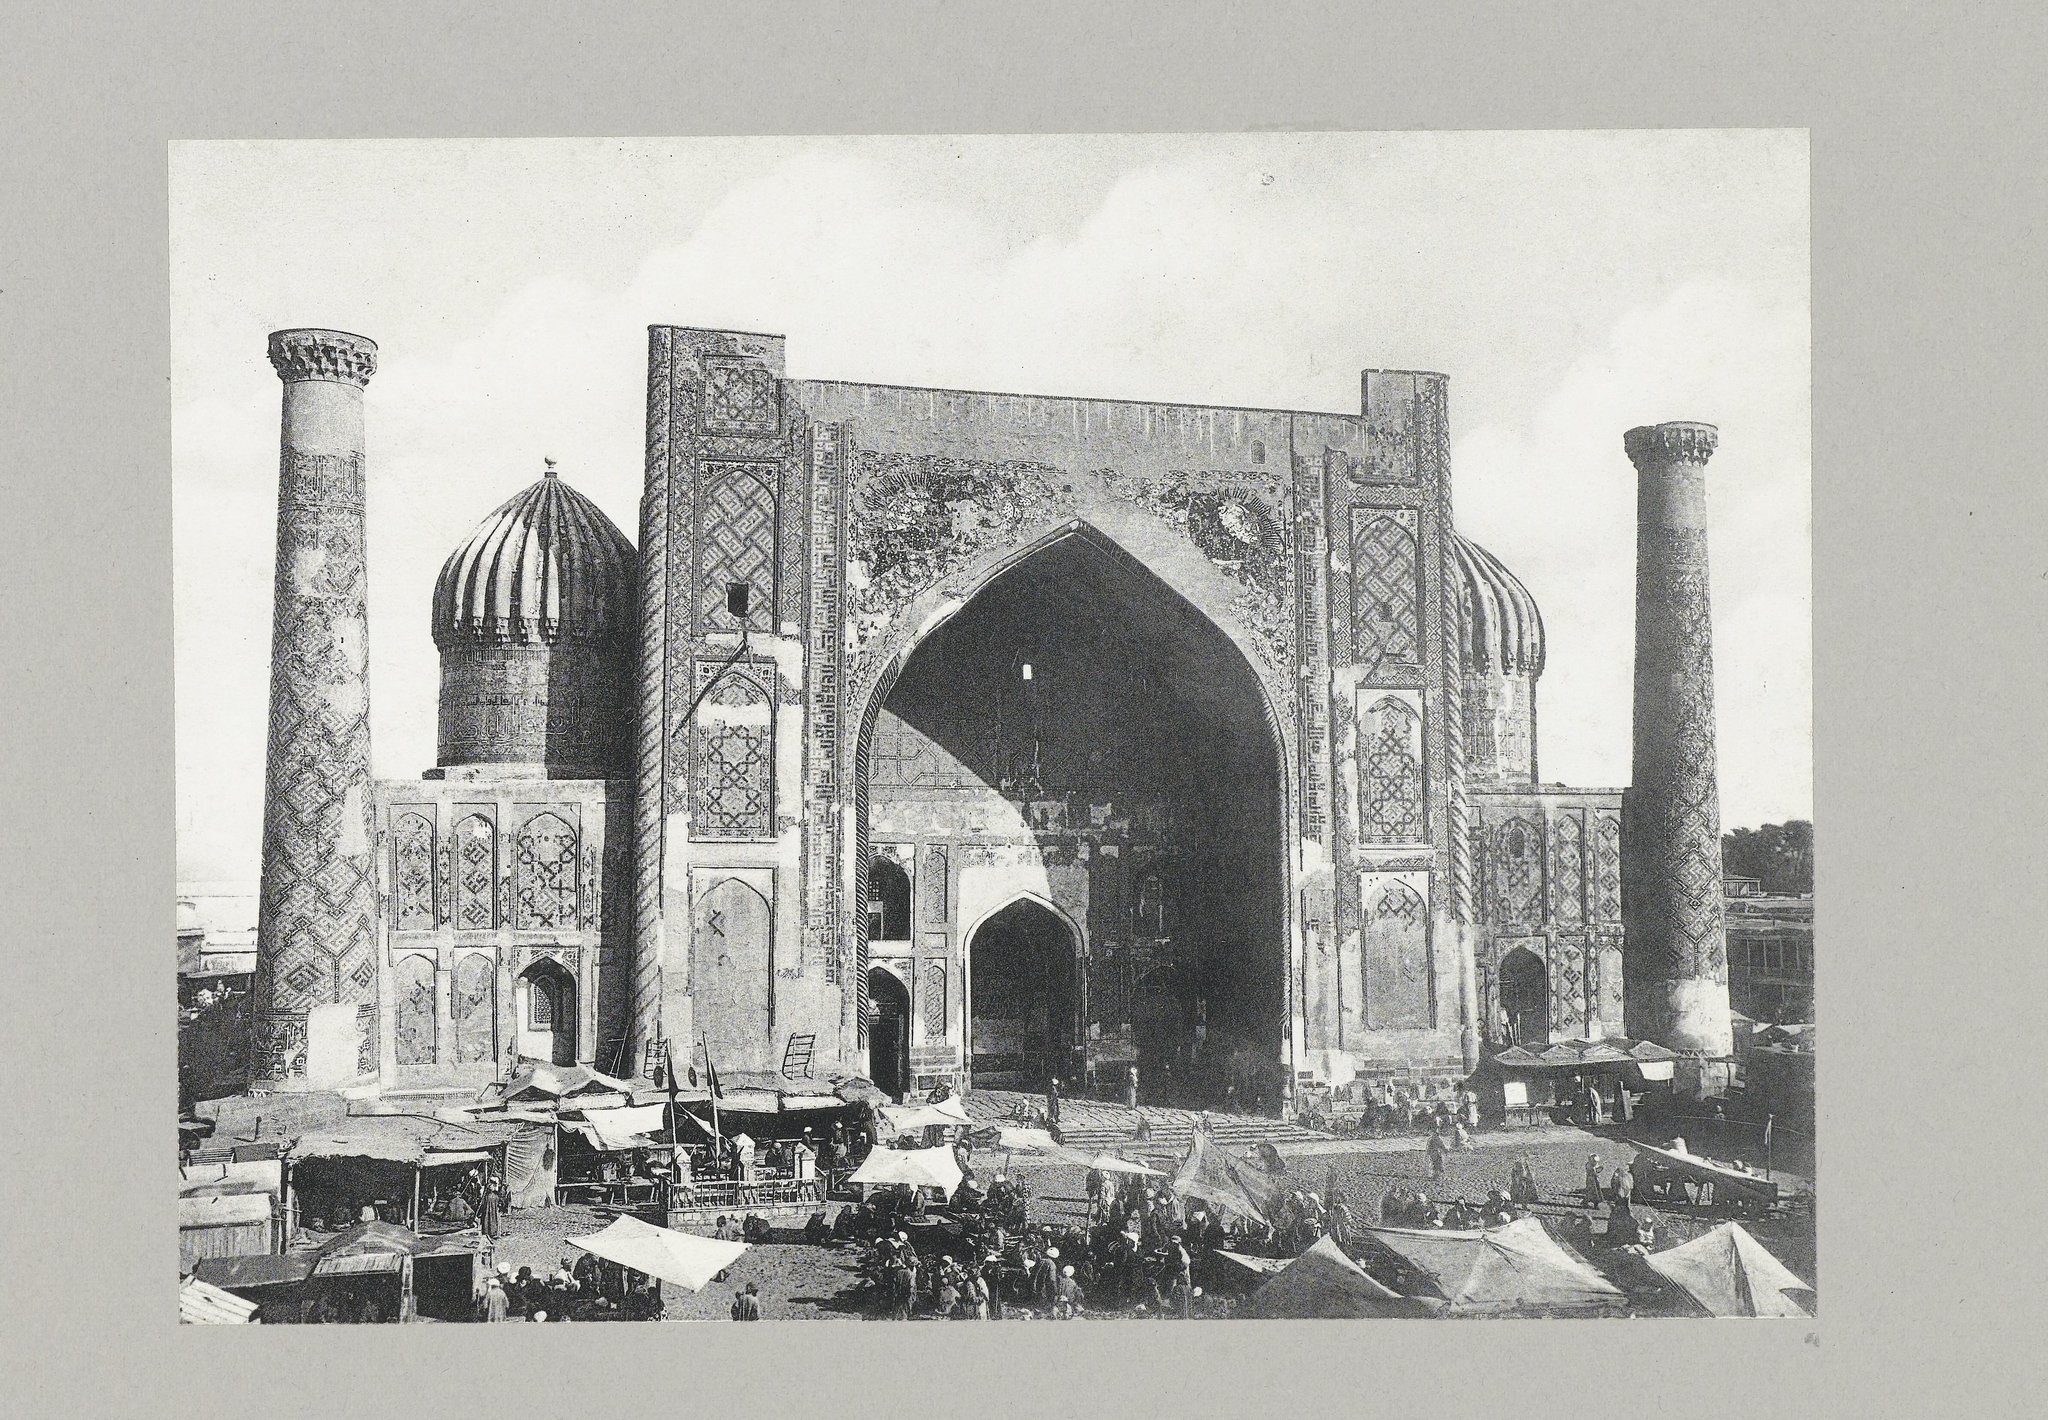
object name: photomechanical print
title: Moskee met scheve minaretten op de marktplaats te Samarkand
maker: Anonymous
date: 1895-1915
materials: cardboard, paper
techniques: photograph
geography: samarqand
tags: samarqand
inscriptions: annotation: ‘8. Moskee met scheeve Minarets op de Marktplaats te Samarkand.’